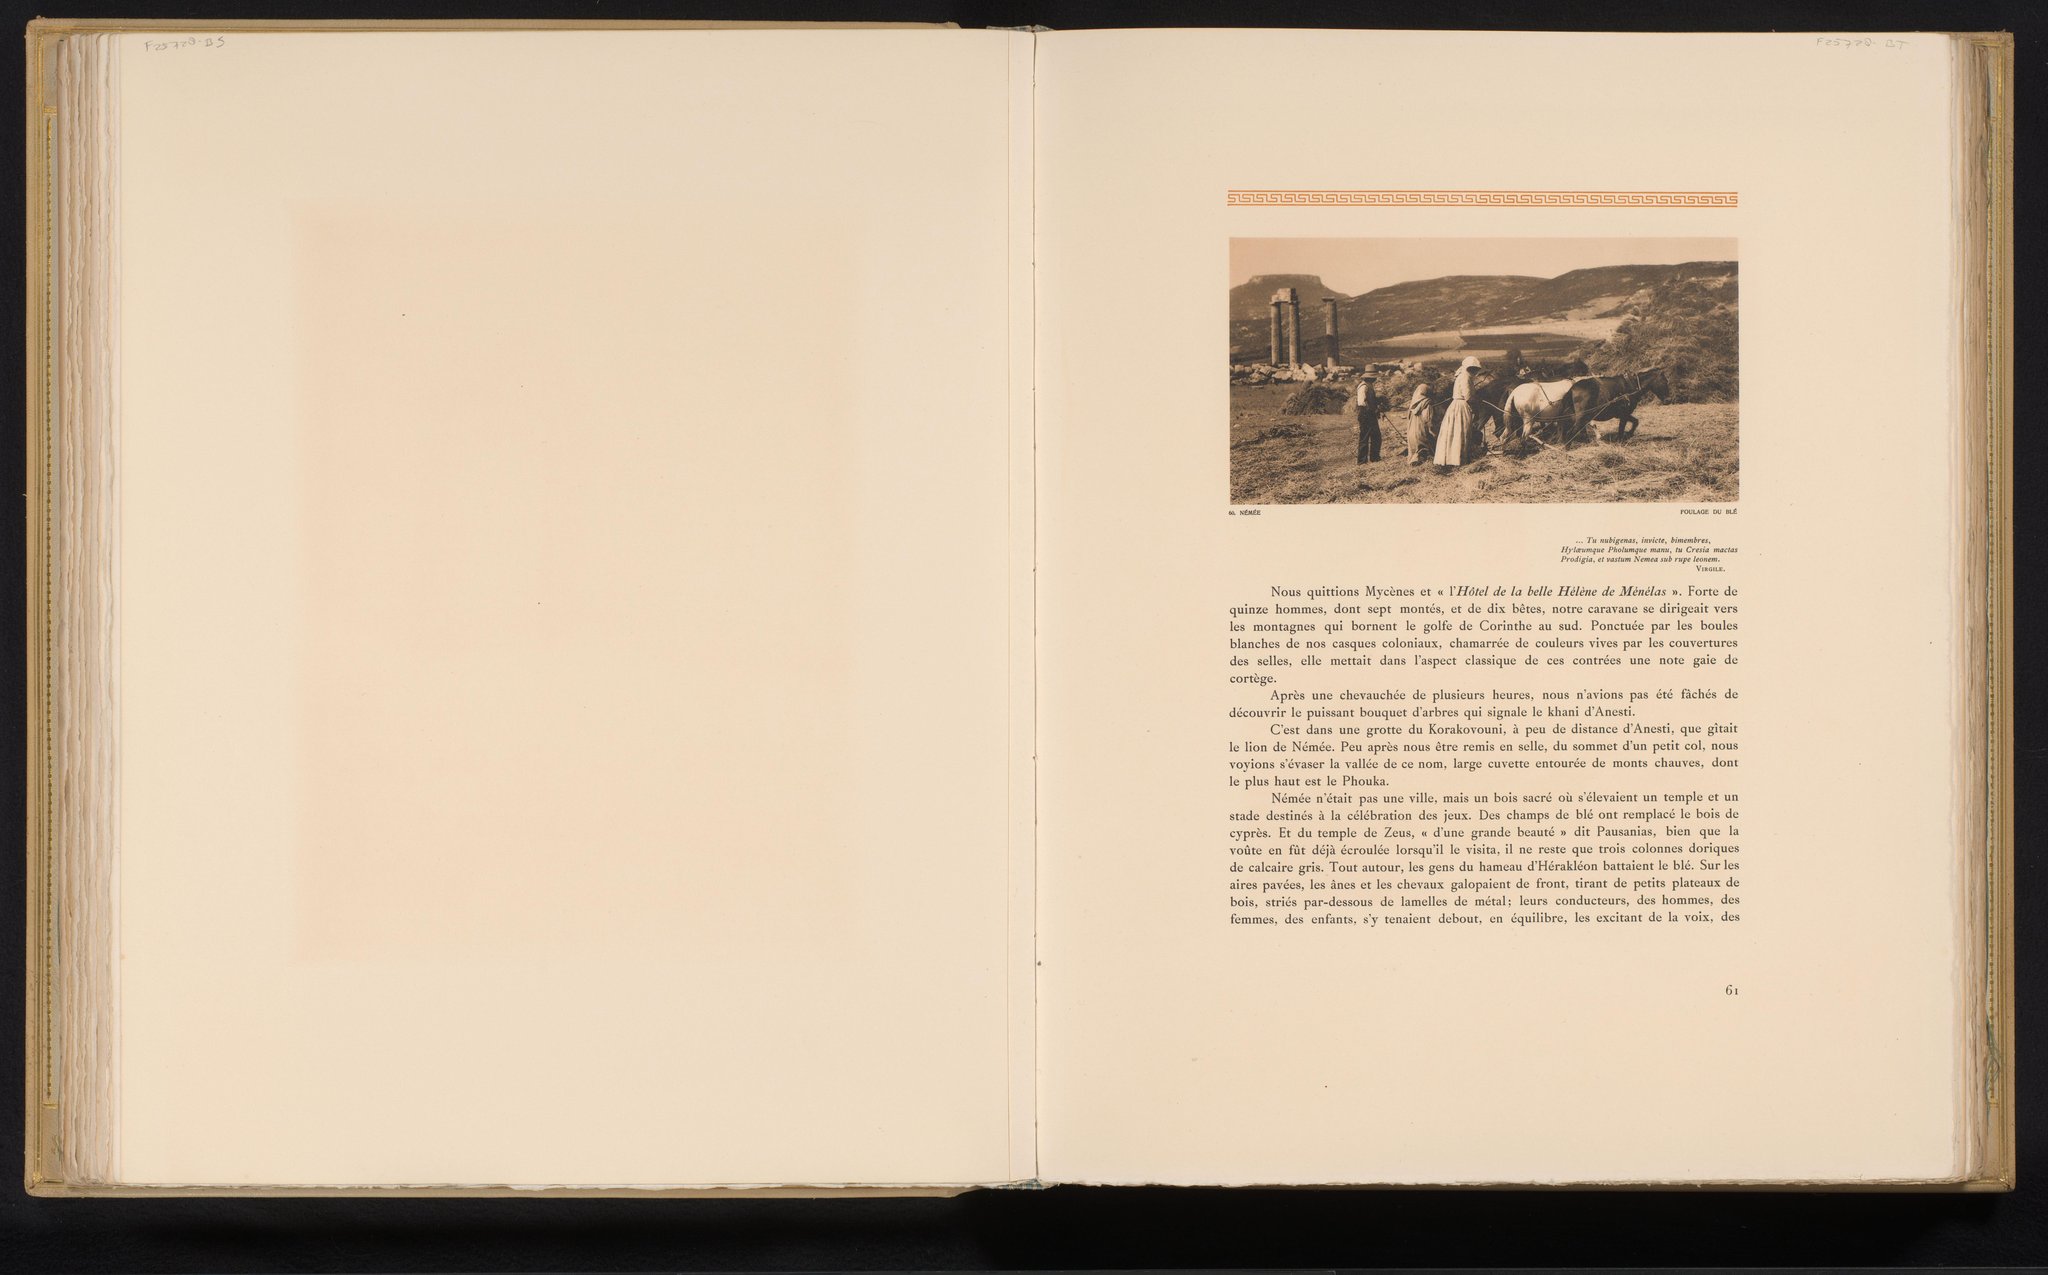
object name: photomechanical print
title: Boeren bewerken het land nabij de ruïnes van de Zeustempel in Nemea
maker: frédéric boissonnas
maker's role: fotograaf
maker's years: 1858-1946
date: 1905-1910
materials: paper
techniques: photograph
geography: berlin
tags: farmers, temple, shrine ~ greek religion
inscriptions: number: ‘60.’